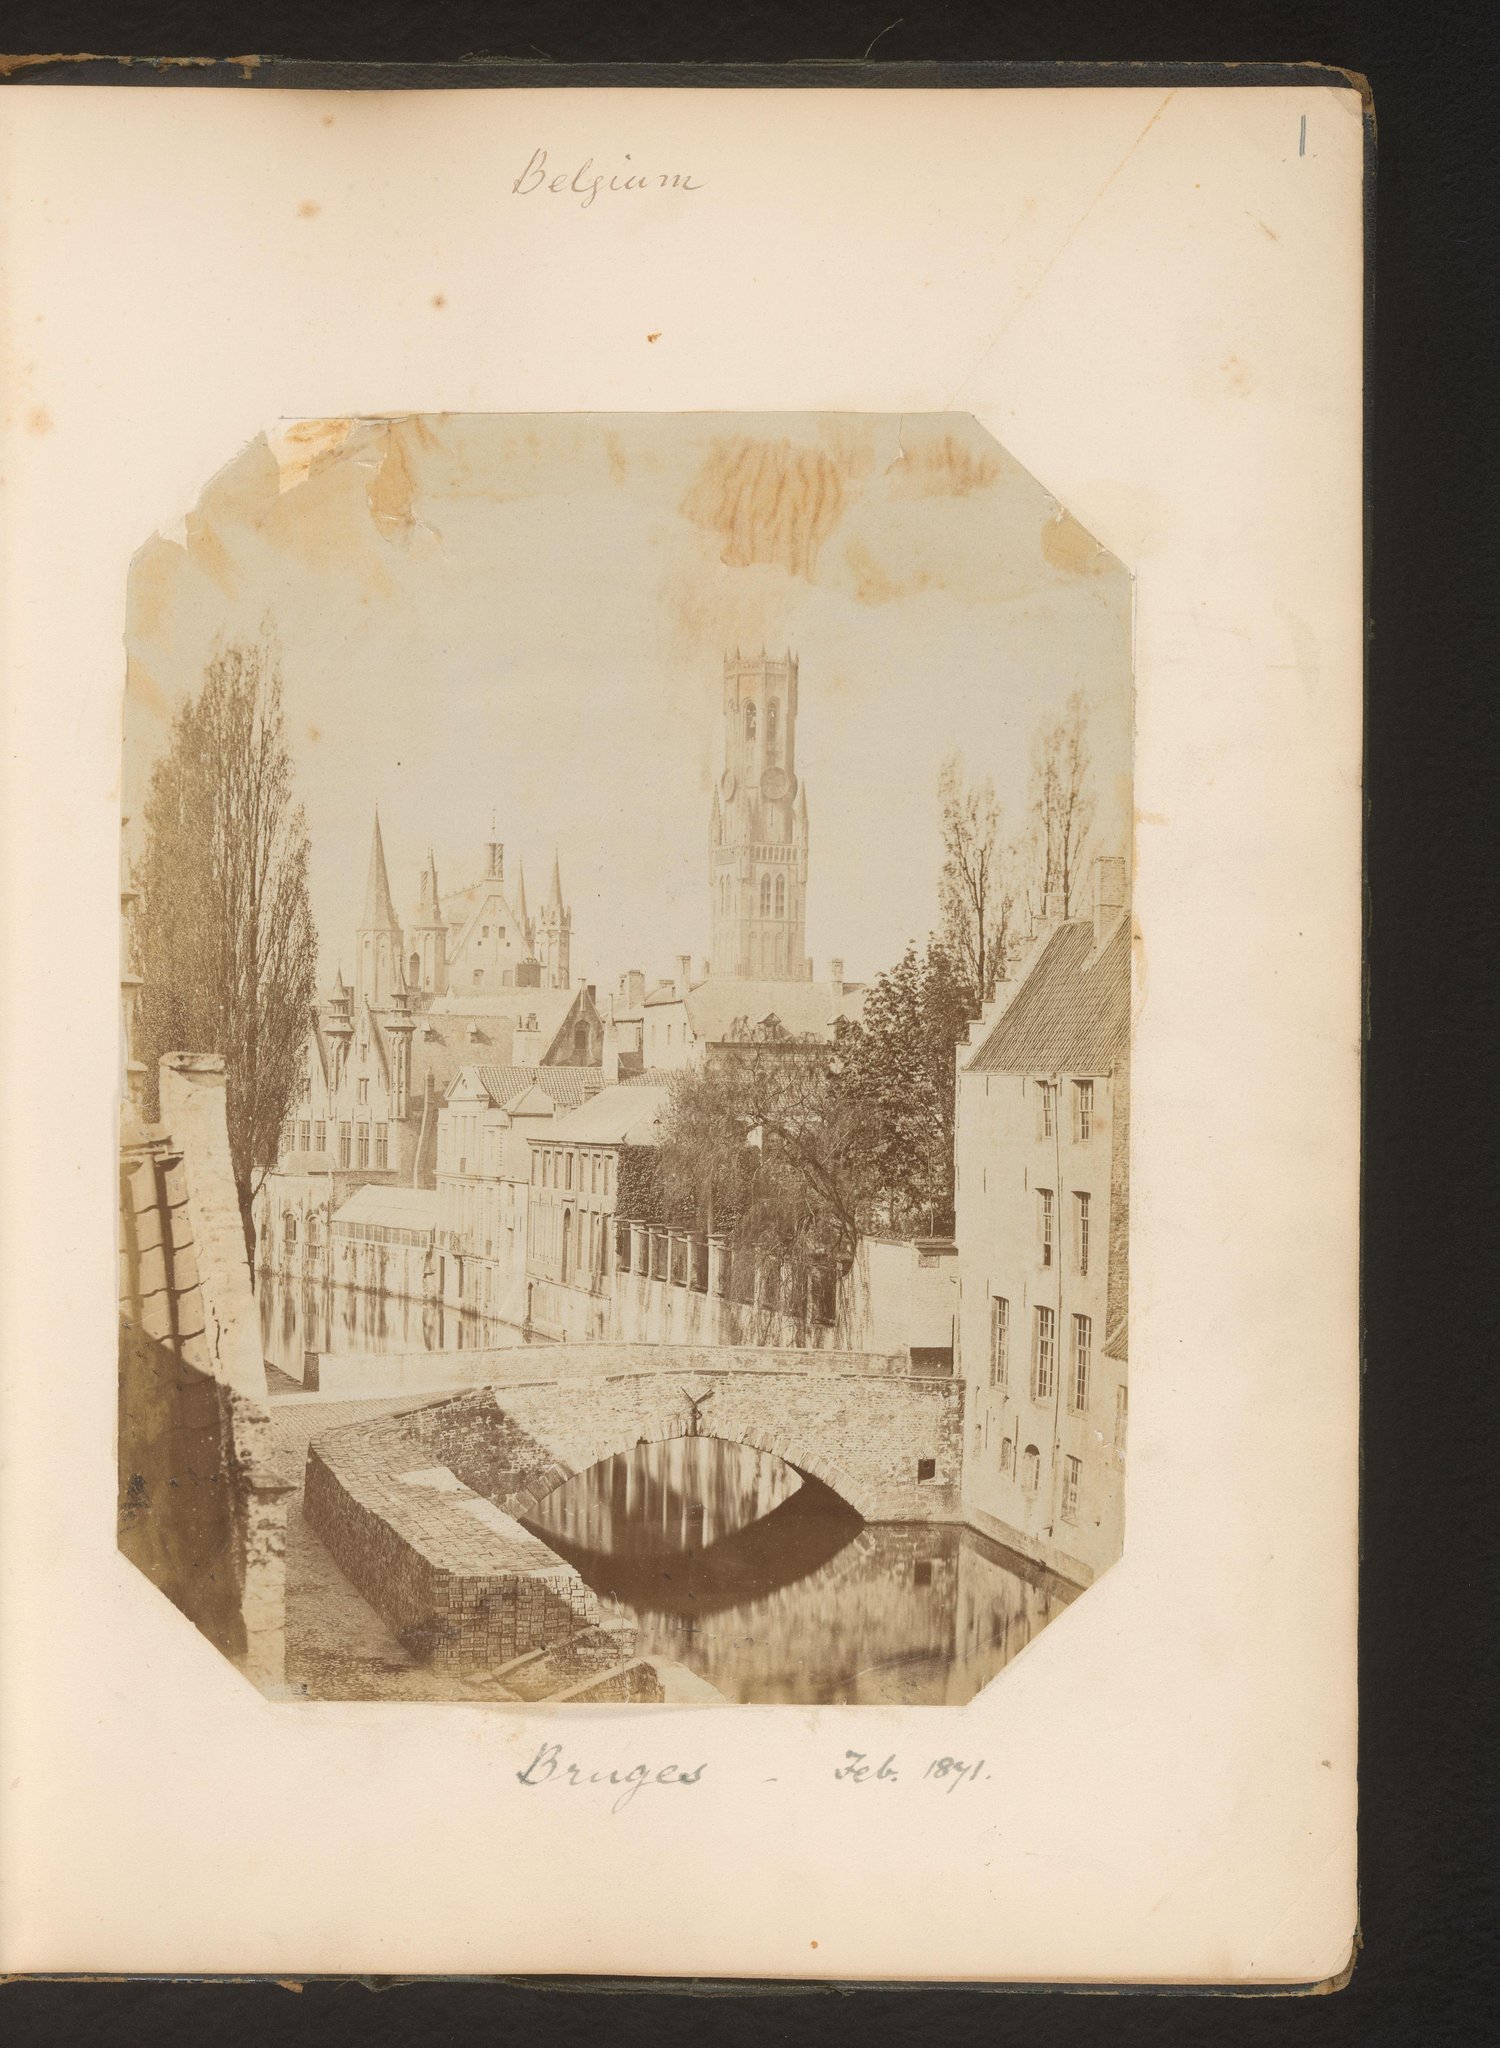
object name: photograph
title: Stadsgezicht te Brugge met onder meer het Belfort en de Onze-Lieve-Vrouwekerk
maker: Anonymous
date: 1802-1871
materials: paper, photographic support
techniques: albumen print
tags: city-view, and landscape with man-made constructions, church (exterior), canals, waters (in city)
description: Deze pagina maakt deel uit van een album.